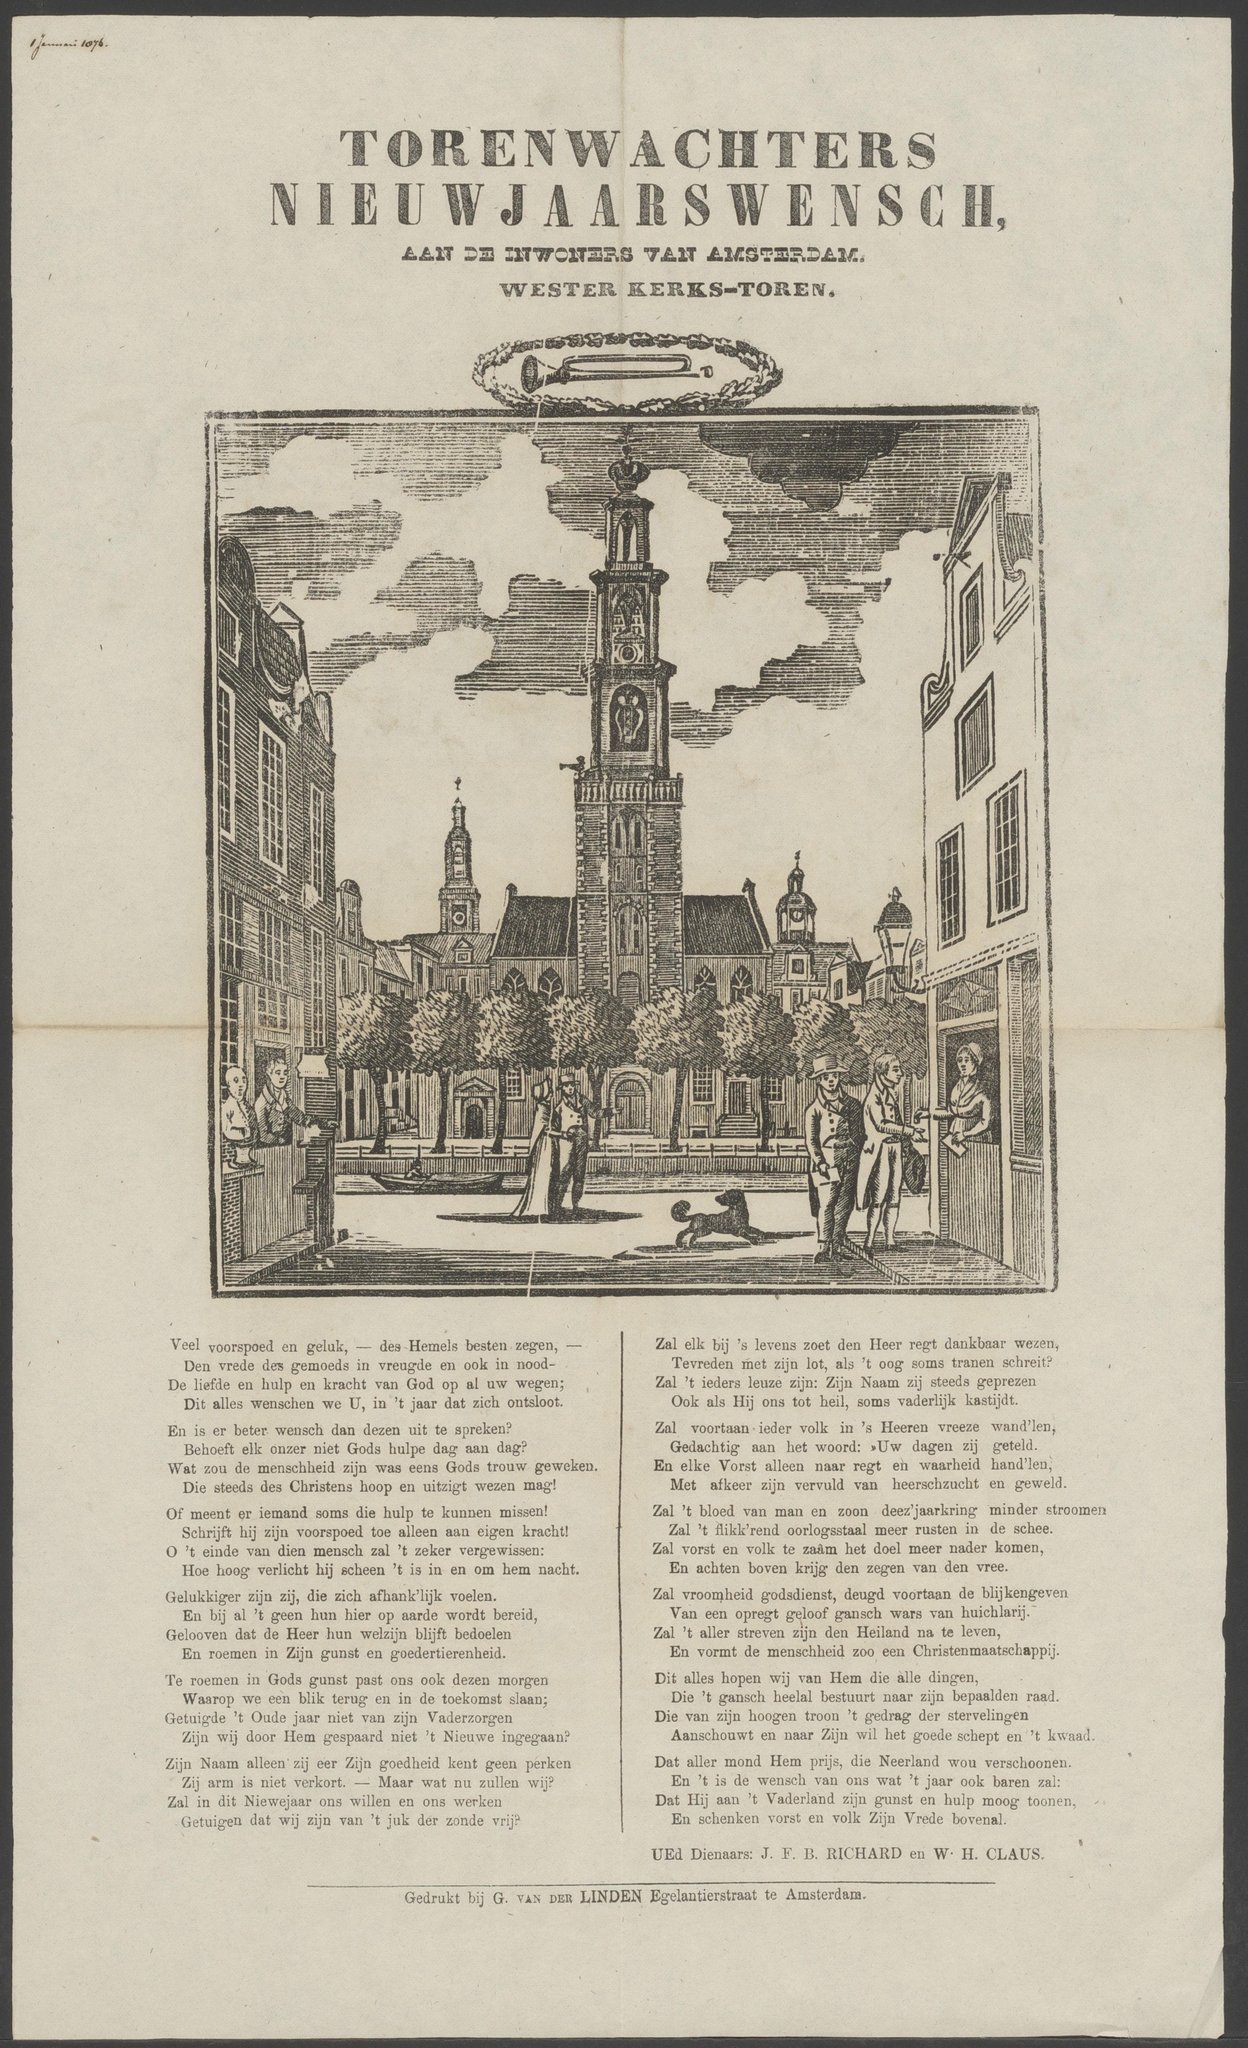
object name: print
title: Torenwachters Nieuwjaarswensch. Opgedragen aan de Inwoners van Amsterdam, Wester kerks-toren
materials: paper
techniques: letterpress printing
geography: amsterdam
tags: parts of church exterior and annexes: tower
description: Nieuwjaarswens van de torenwachters van de Westerkerkstoren te Amsterdam. Bovenaan een gezicht op een kerktoren. Daaronder centraal een gedicht in twee kolommen. Aangeboden door de torenwachters: J.F.B. Richard en W.H. Claus. Onderwerpsrubrieken binnen de Atlas Zeden en Gewoonten: Zeden en gewoonten in engeren zin, Volksleven, Volksbladen, Nieuwjaars- en Kerstwenschen, Amsterdam.